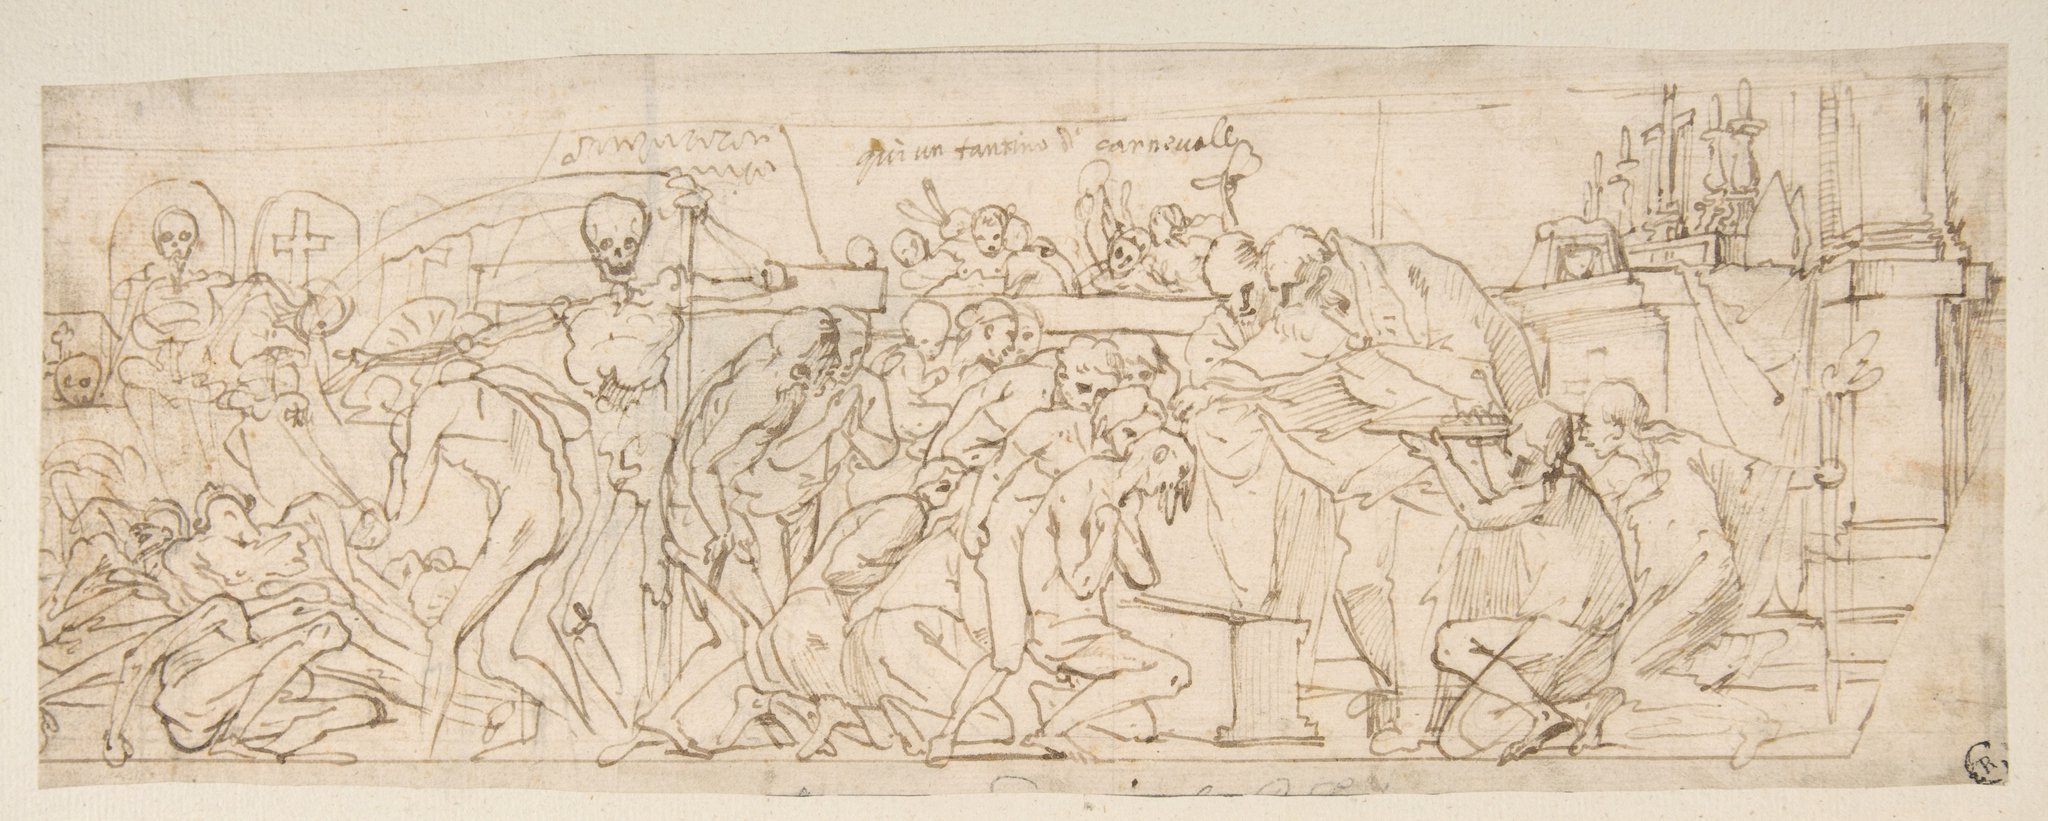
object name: drawing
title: Allegory of Penance and Death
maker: pietro testa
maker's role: artist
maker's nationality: italian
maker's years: 1612-1650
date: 1612-1650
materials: chalk, ink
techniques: pen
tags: altars,skeletons,male nudes